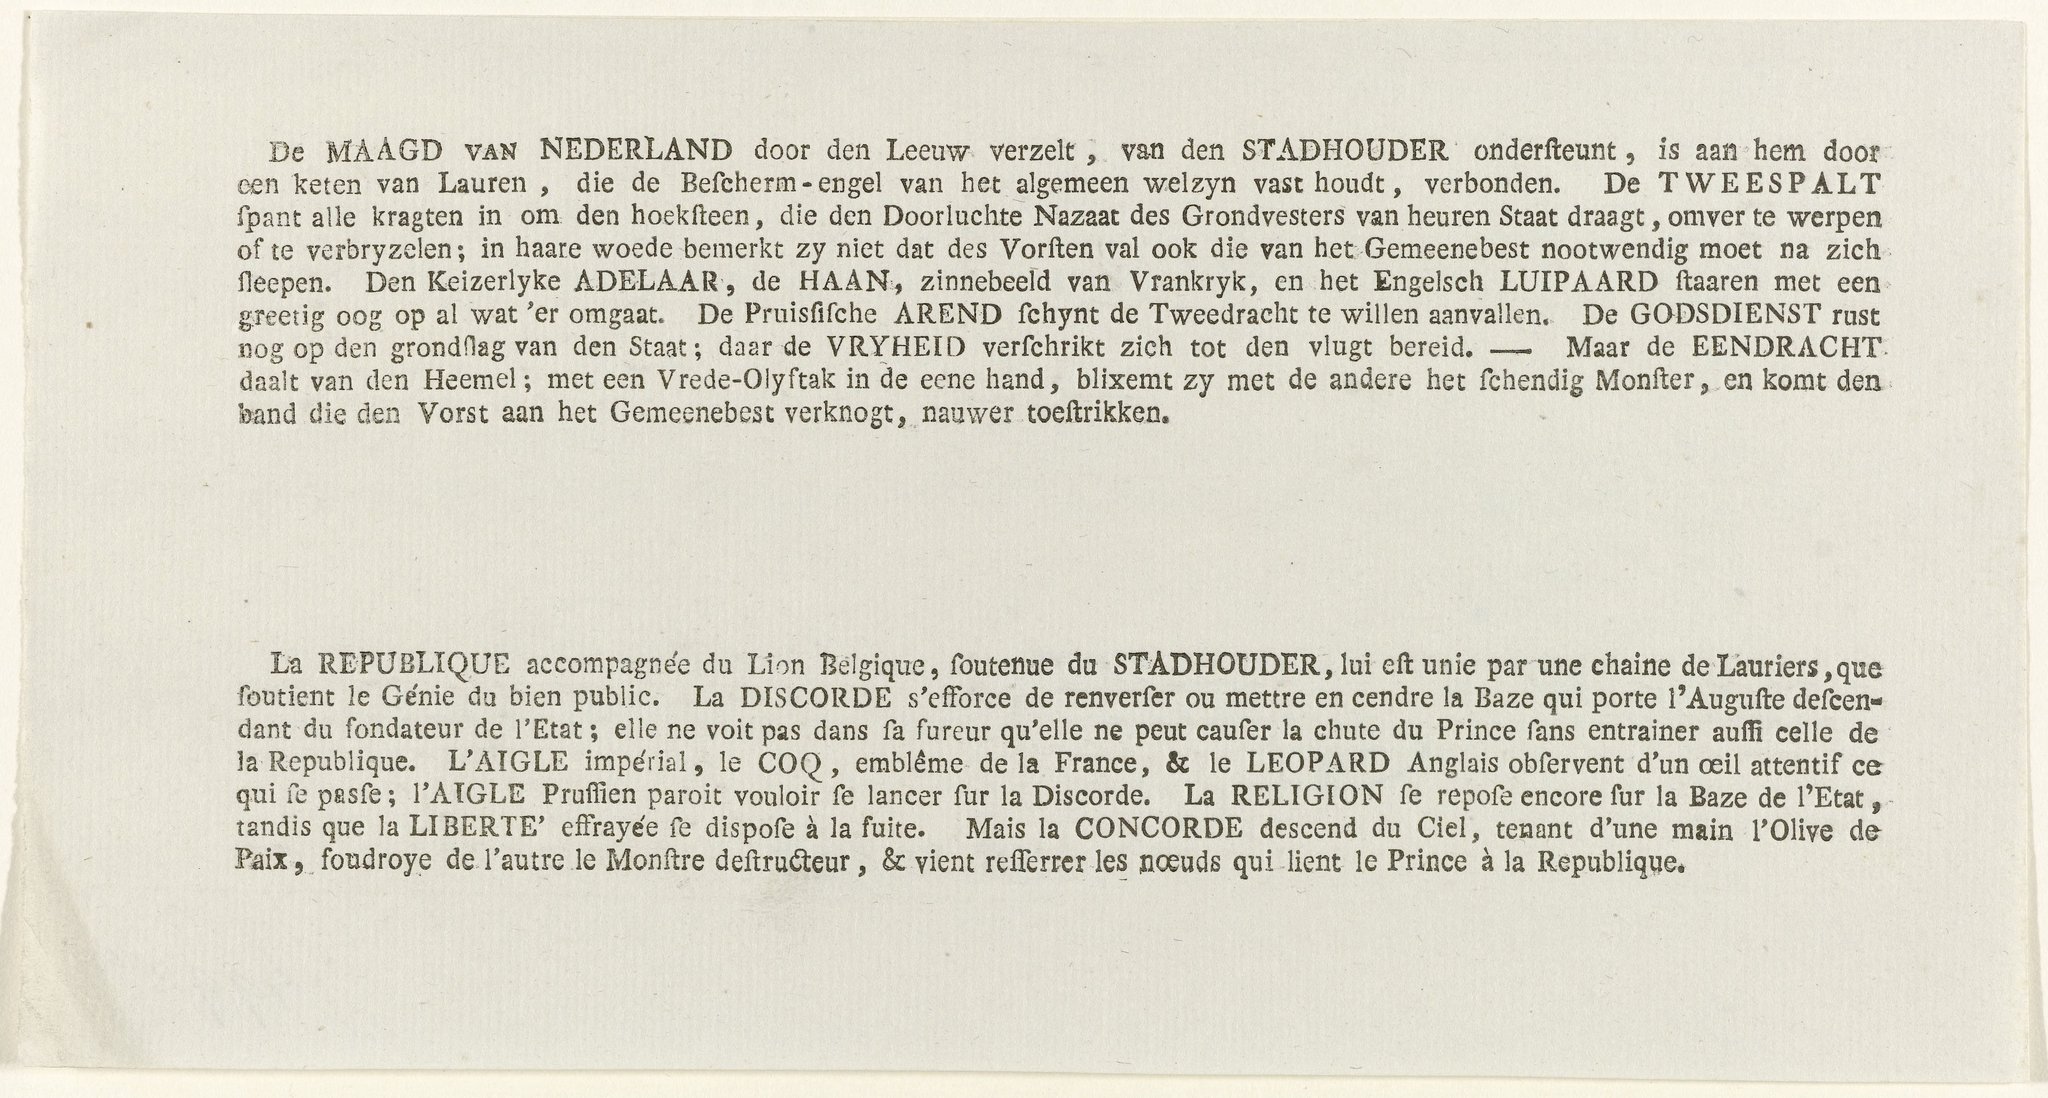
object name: print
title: Allegorie op het herstel van Willem V als stadhouder, 1787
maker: Anonymous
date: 1787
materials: paper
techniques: engraving, etching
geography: northern netherlands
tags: the hague, william v (prince of orange), personifications of countries, nations, states, districts, etc., disagreement, discord; 'discordia' (ripa) (+ abstract concept represented by female figure), agreement, unity; 'concordia', 'concordia insuperabile', 'concordia militare', 'concordia di pace', 'unione civile' (ripa) (+ abstract concept represented by female figure), netherlands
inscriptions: collector's mark: Lugt 2228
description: Orangistische allegorie op het herstel van stadhouder Willem V in 1787. De stadhouder staande op een hoeksteen met de Nederlandse Maagd en Leeuw. Tweedracht probeert tevergeefs de hoeksteen van het Staatsgebouw omver te werpen. Een Pruisische adelaar verjaaagt de Franse haan en de Engelse panter. De Eendracht laat vanuit de hemel bliksemschichten neerdalen op de Tweedracht. Met onderschrift in twee kolommen. Bij de prent behoort ook een afzonderlijke verklaring.